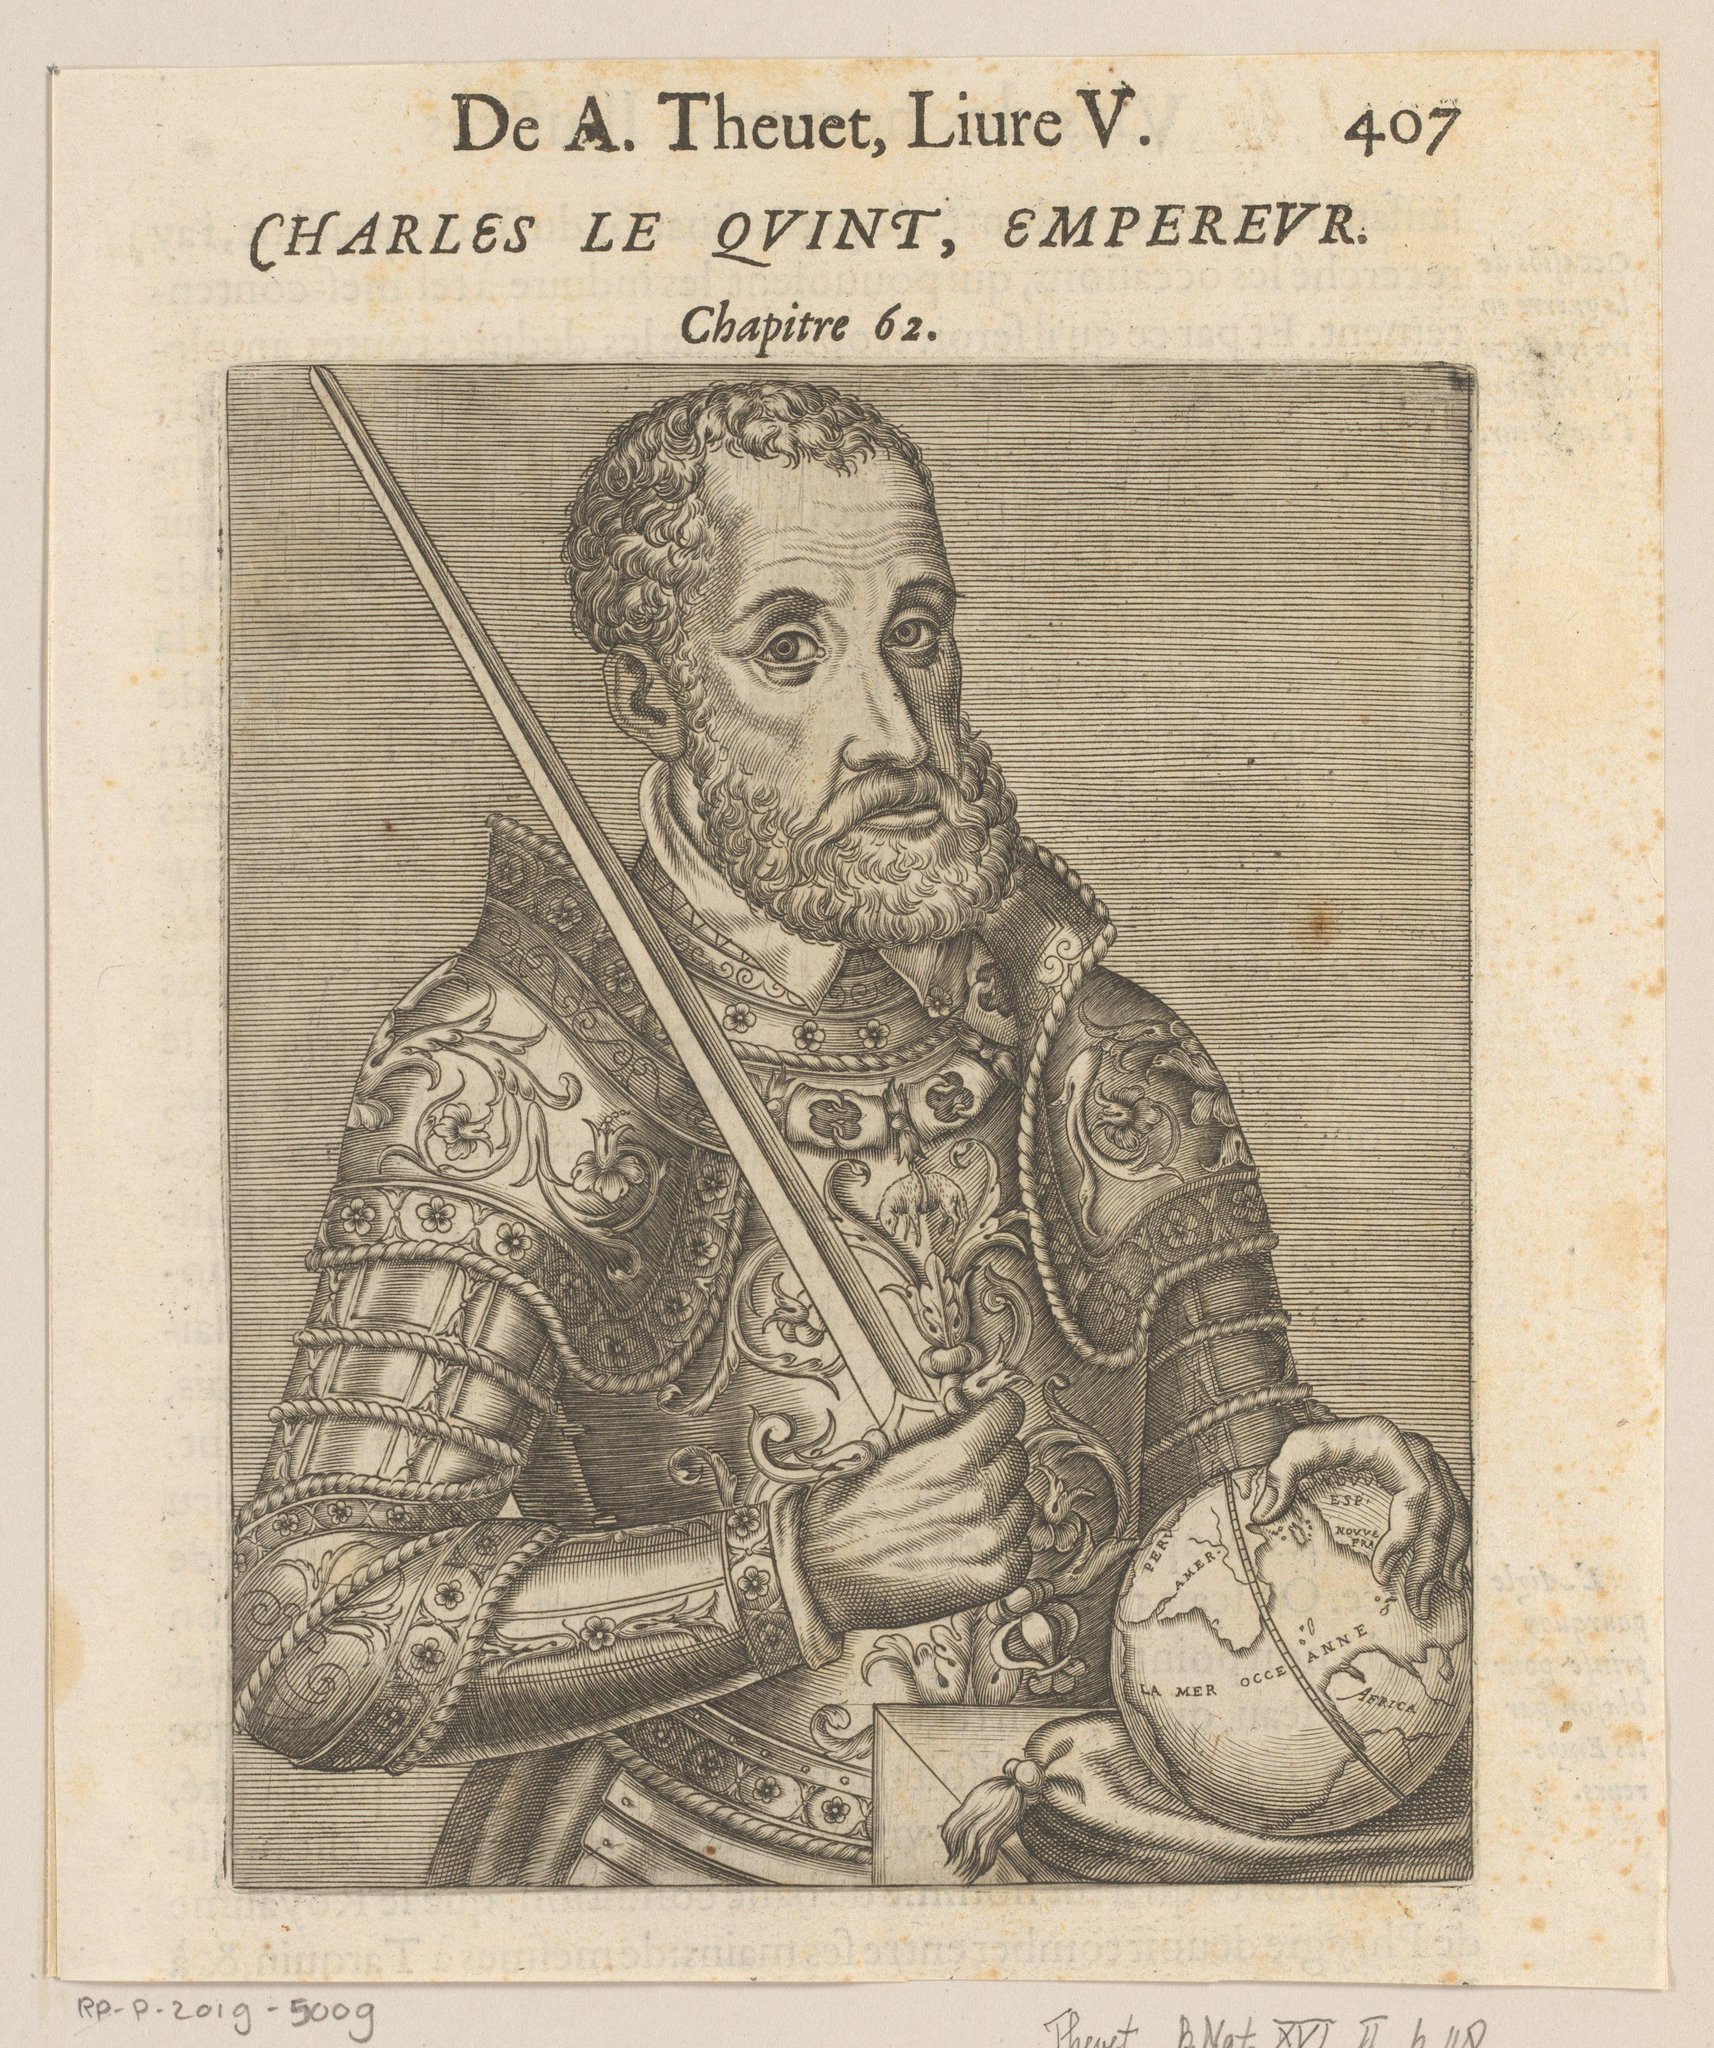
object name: book illustration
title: Portret van keizer Karel V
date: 1584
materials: paper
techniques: engraving, etching, letterpress printing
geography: paris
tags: ghent, charles v (holy roman emperor and king of spain), armour, historical persons, hacking and thrusting weapons: sword, knighthood order of the golden fleece - insignia of a knighthood order, e.g.: badge, chain (with name of order), globe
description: Prent uit: Thevet, André. Les vrais pourtraits et vies des hommes illustres grecz, latins et payens (...). Parijs: weduwe Jacques Kerver en Guillaume Chaudière, 1584, dl. 2, f. 407.